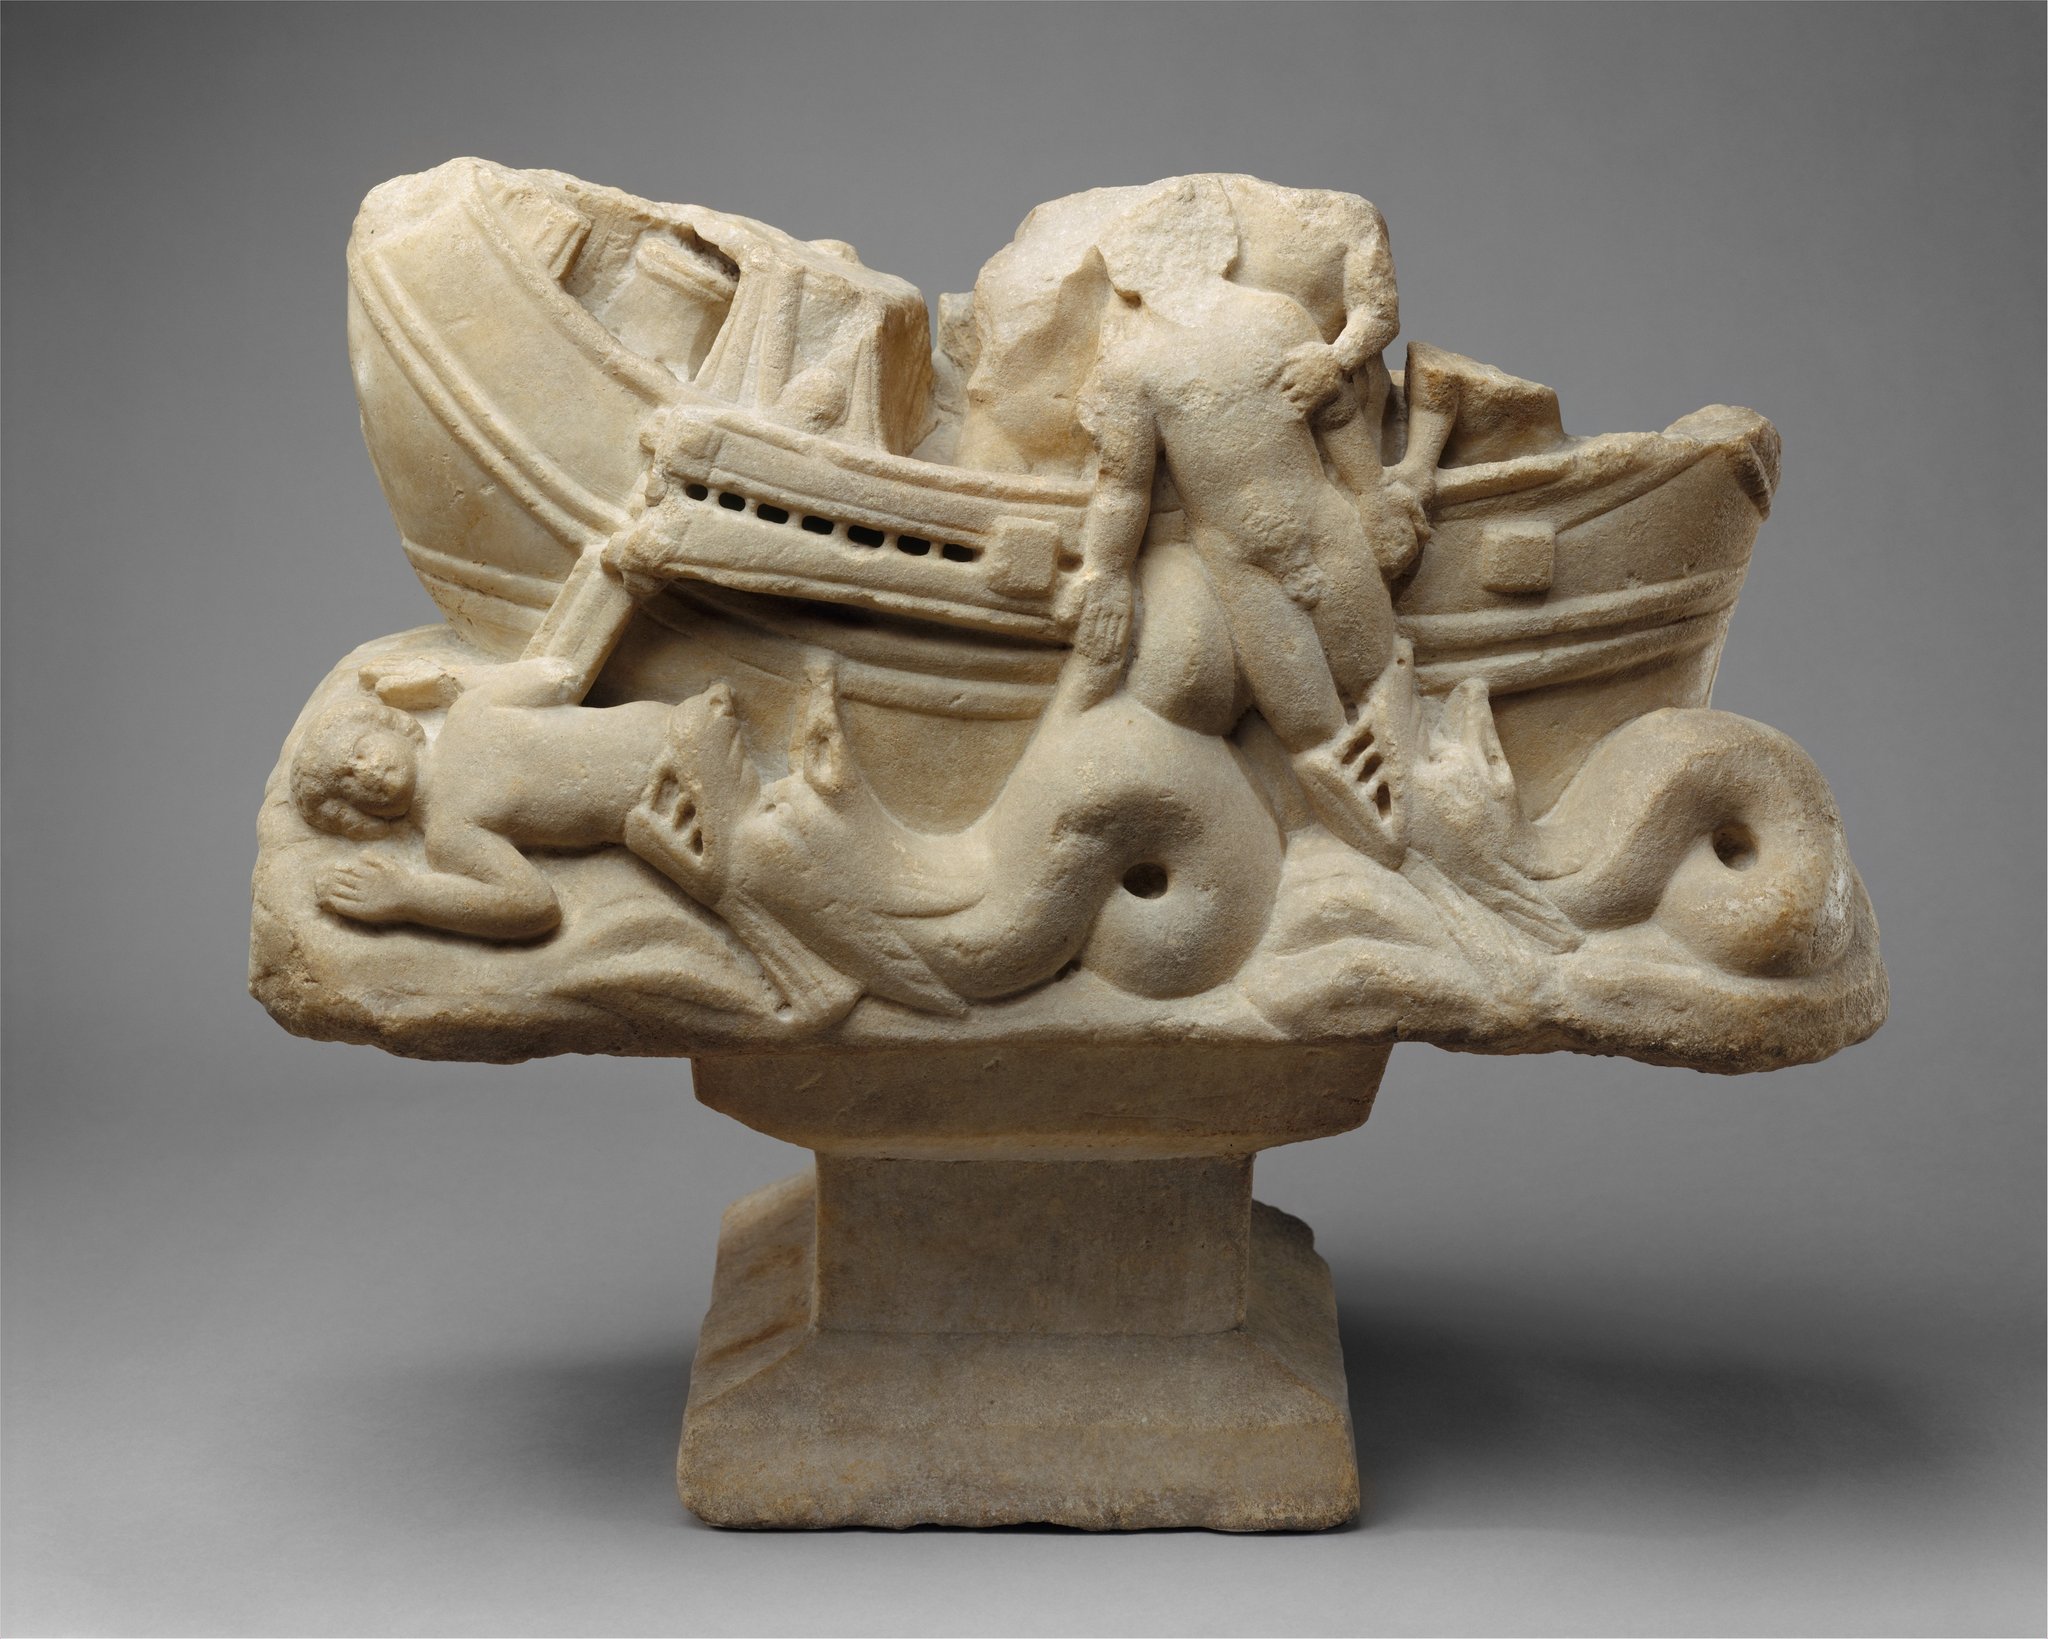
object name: sculpture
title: Table Base with Jonah Swallowed and Cast Up by the Big Fish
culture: roman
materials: marble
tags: men,monsters,boats